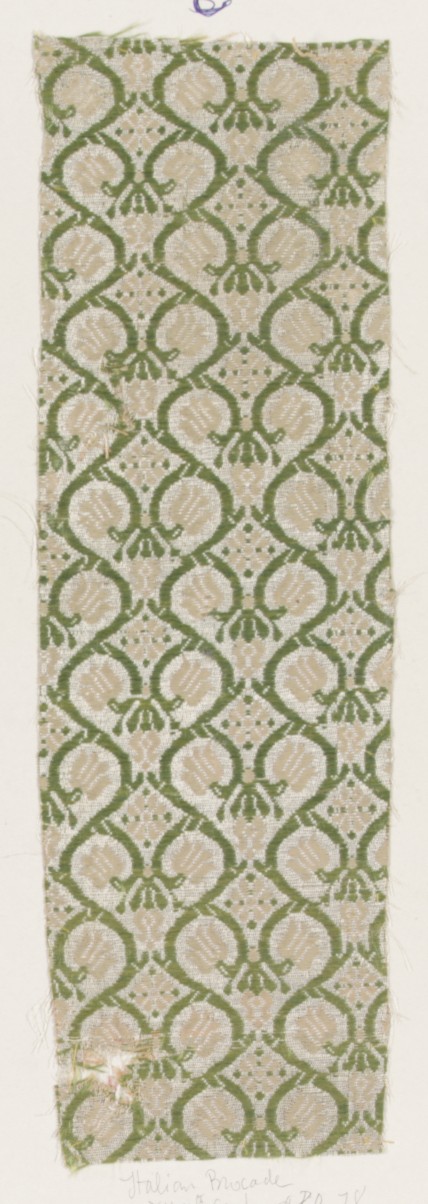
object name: fragment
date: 1701-1800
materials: metal thread, silk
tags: flowers